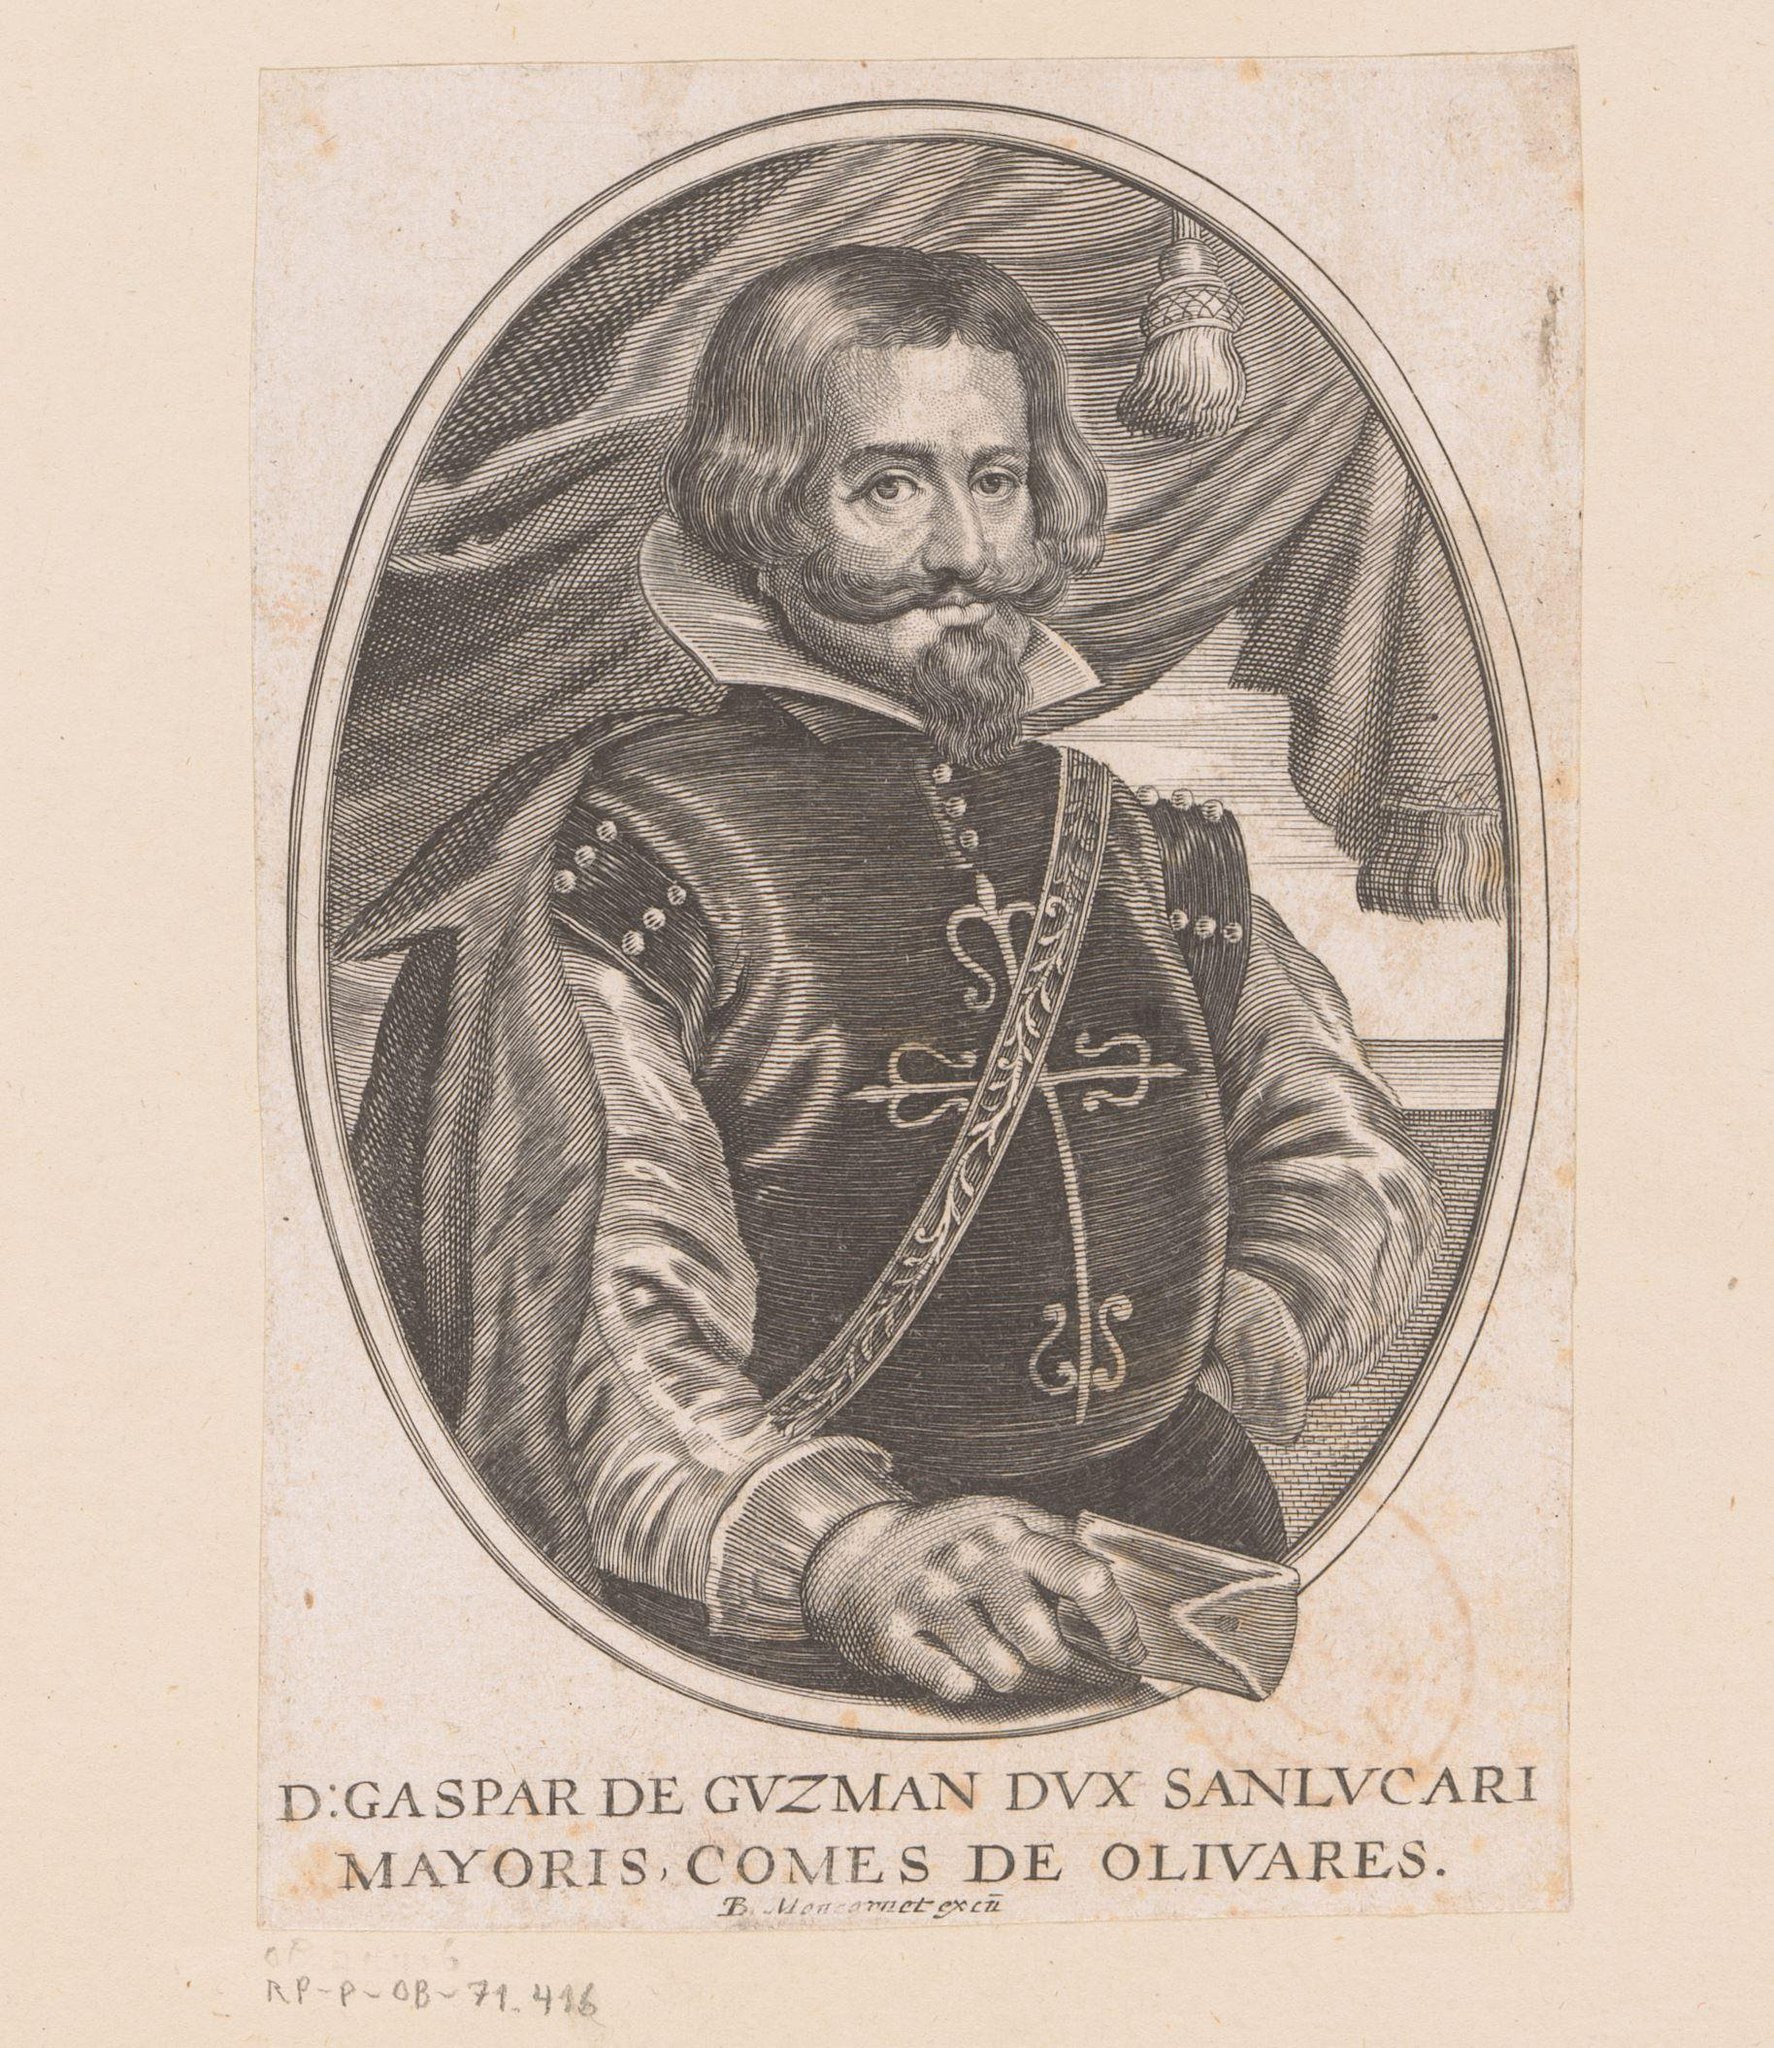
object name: print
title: Portret van Gaspar de Guzmán y Pimentel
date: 1617-1668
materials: paper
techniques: engraving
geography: paris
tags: rome, historical persons, nobility and patriciate; chivalry, knighthood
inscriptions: collector's mark: Lugt 240